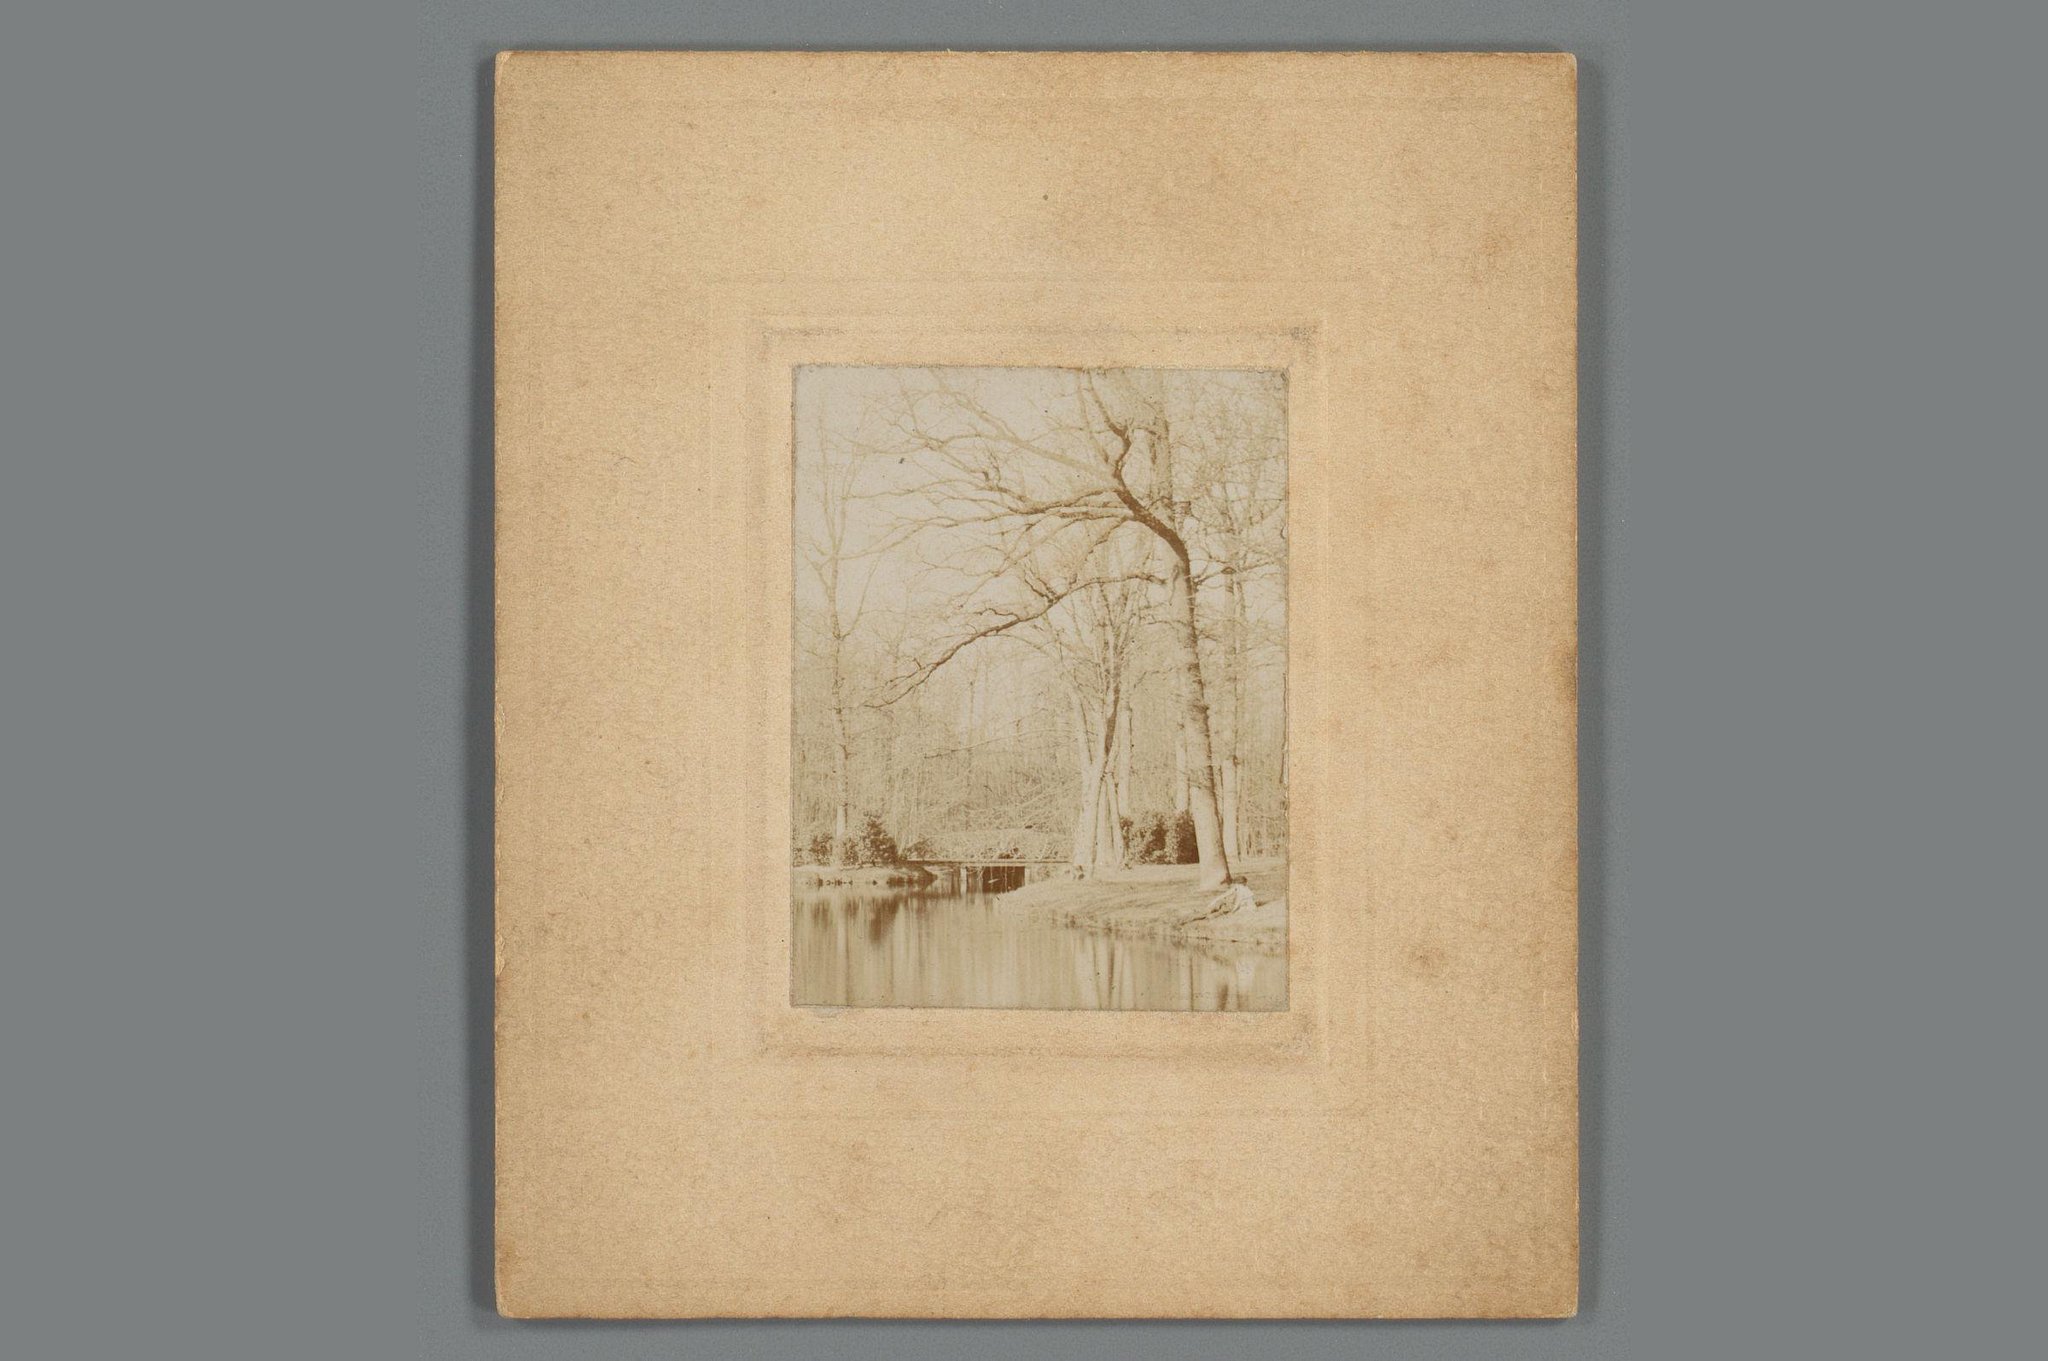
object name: photograph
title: Liggende man aan het water in een park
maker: Anonymous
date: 1890-1920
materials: paper, cardboard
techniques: gelatin silver print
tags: park, adult man, water course